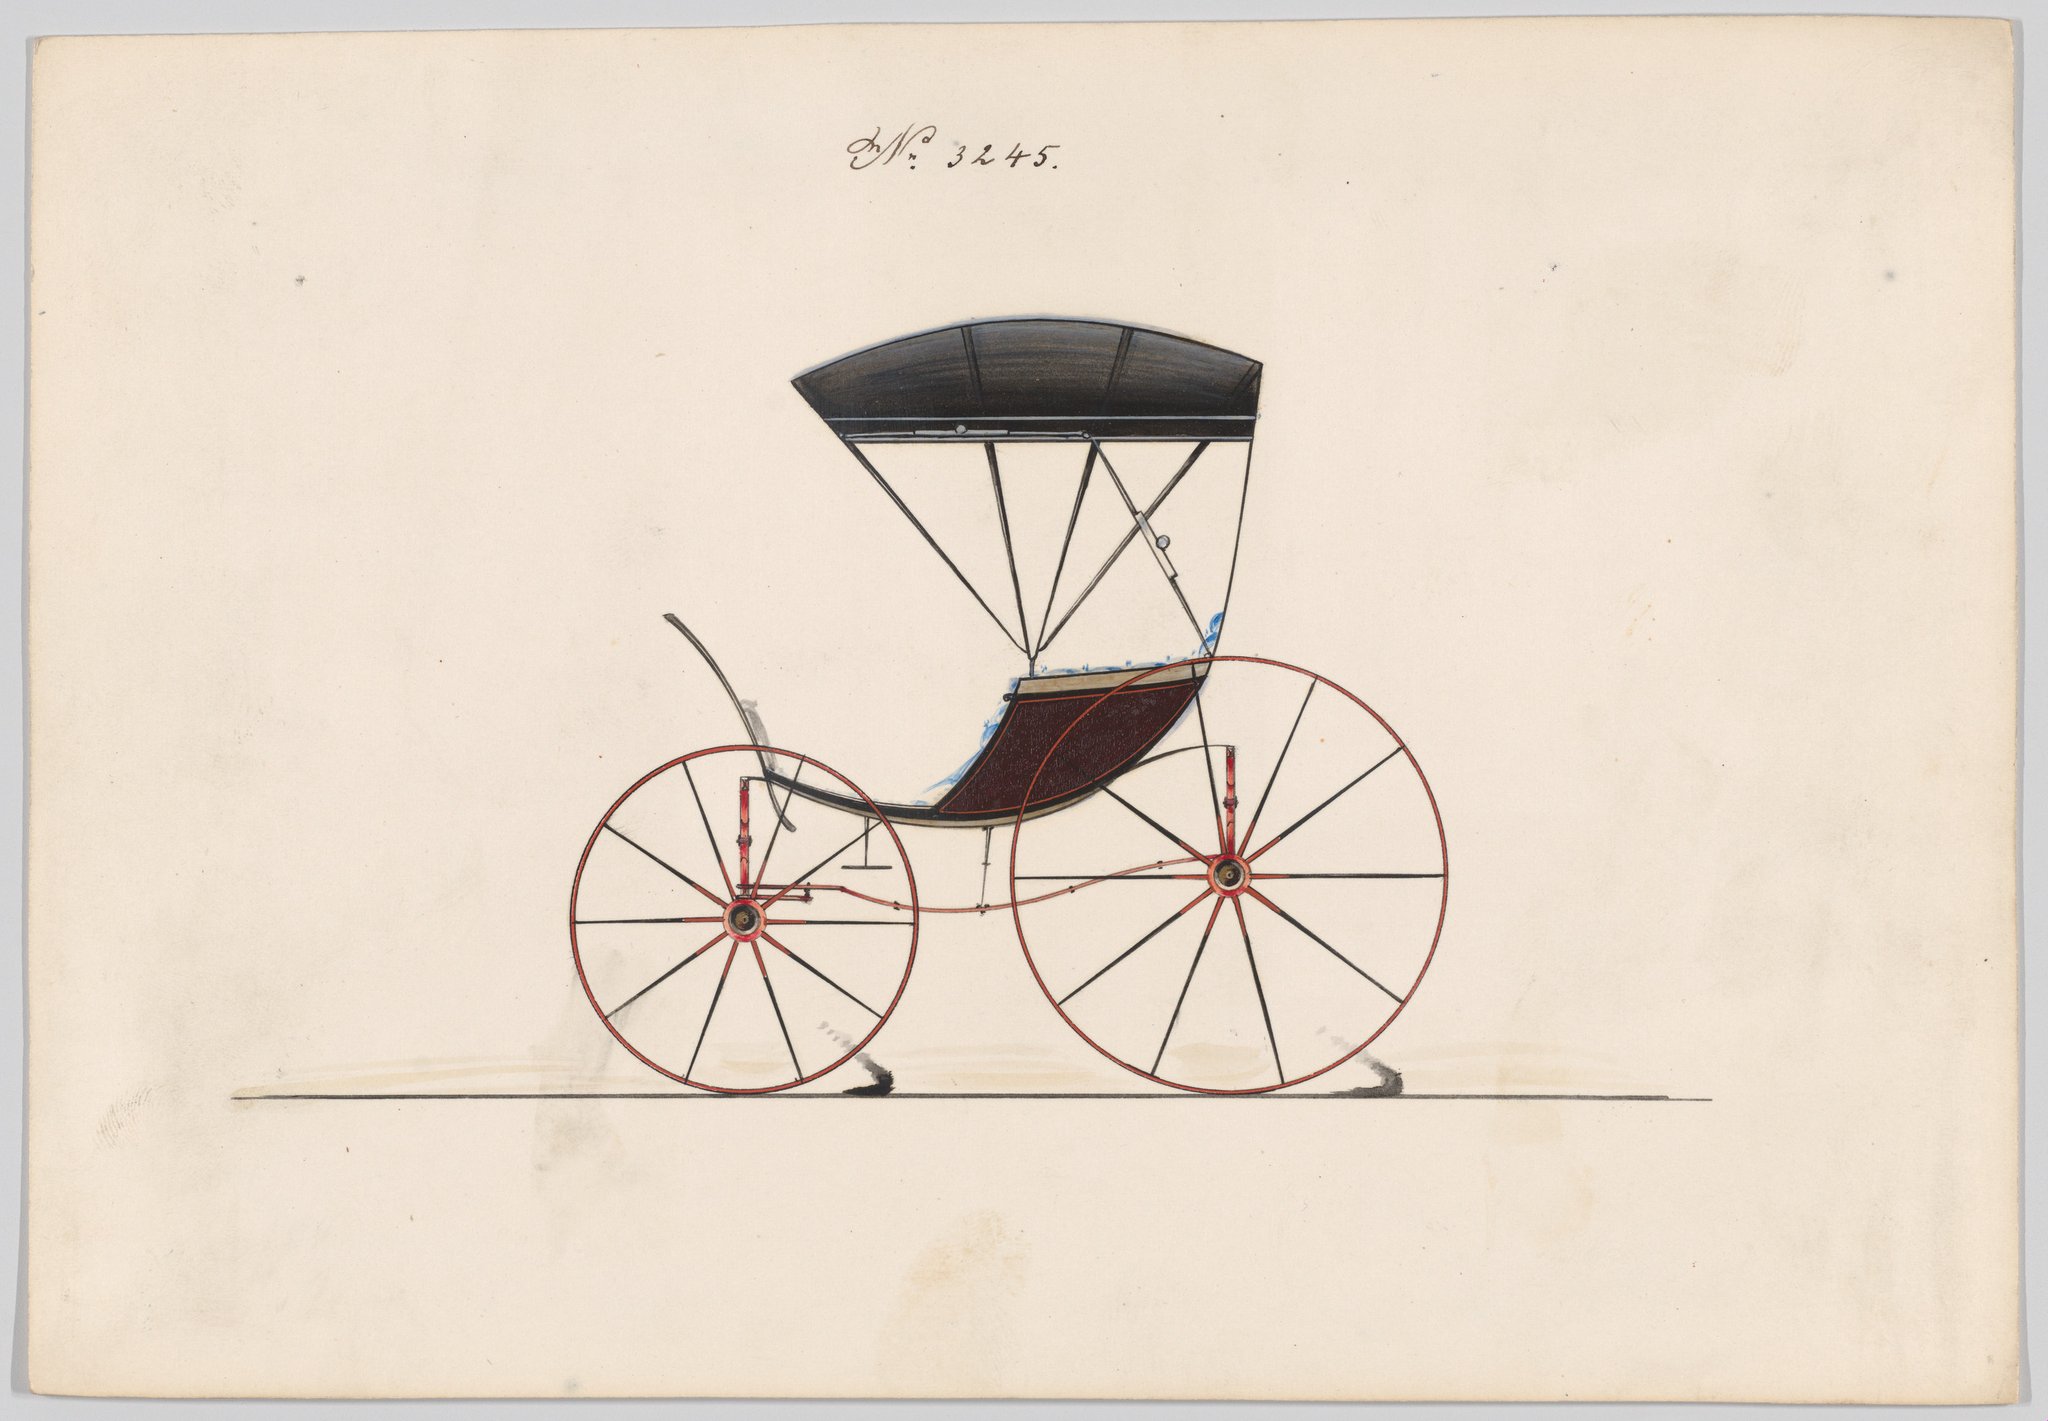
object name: drawing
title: Design for Pony Phaeton, no. 3245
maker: brewster & co.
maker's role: manufacturer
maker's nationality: american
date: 1876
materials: gouache, gum arabic, ink, watercolor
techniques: pen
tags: carriages